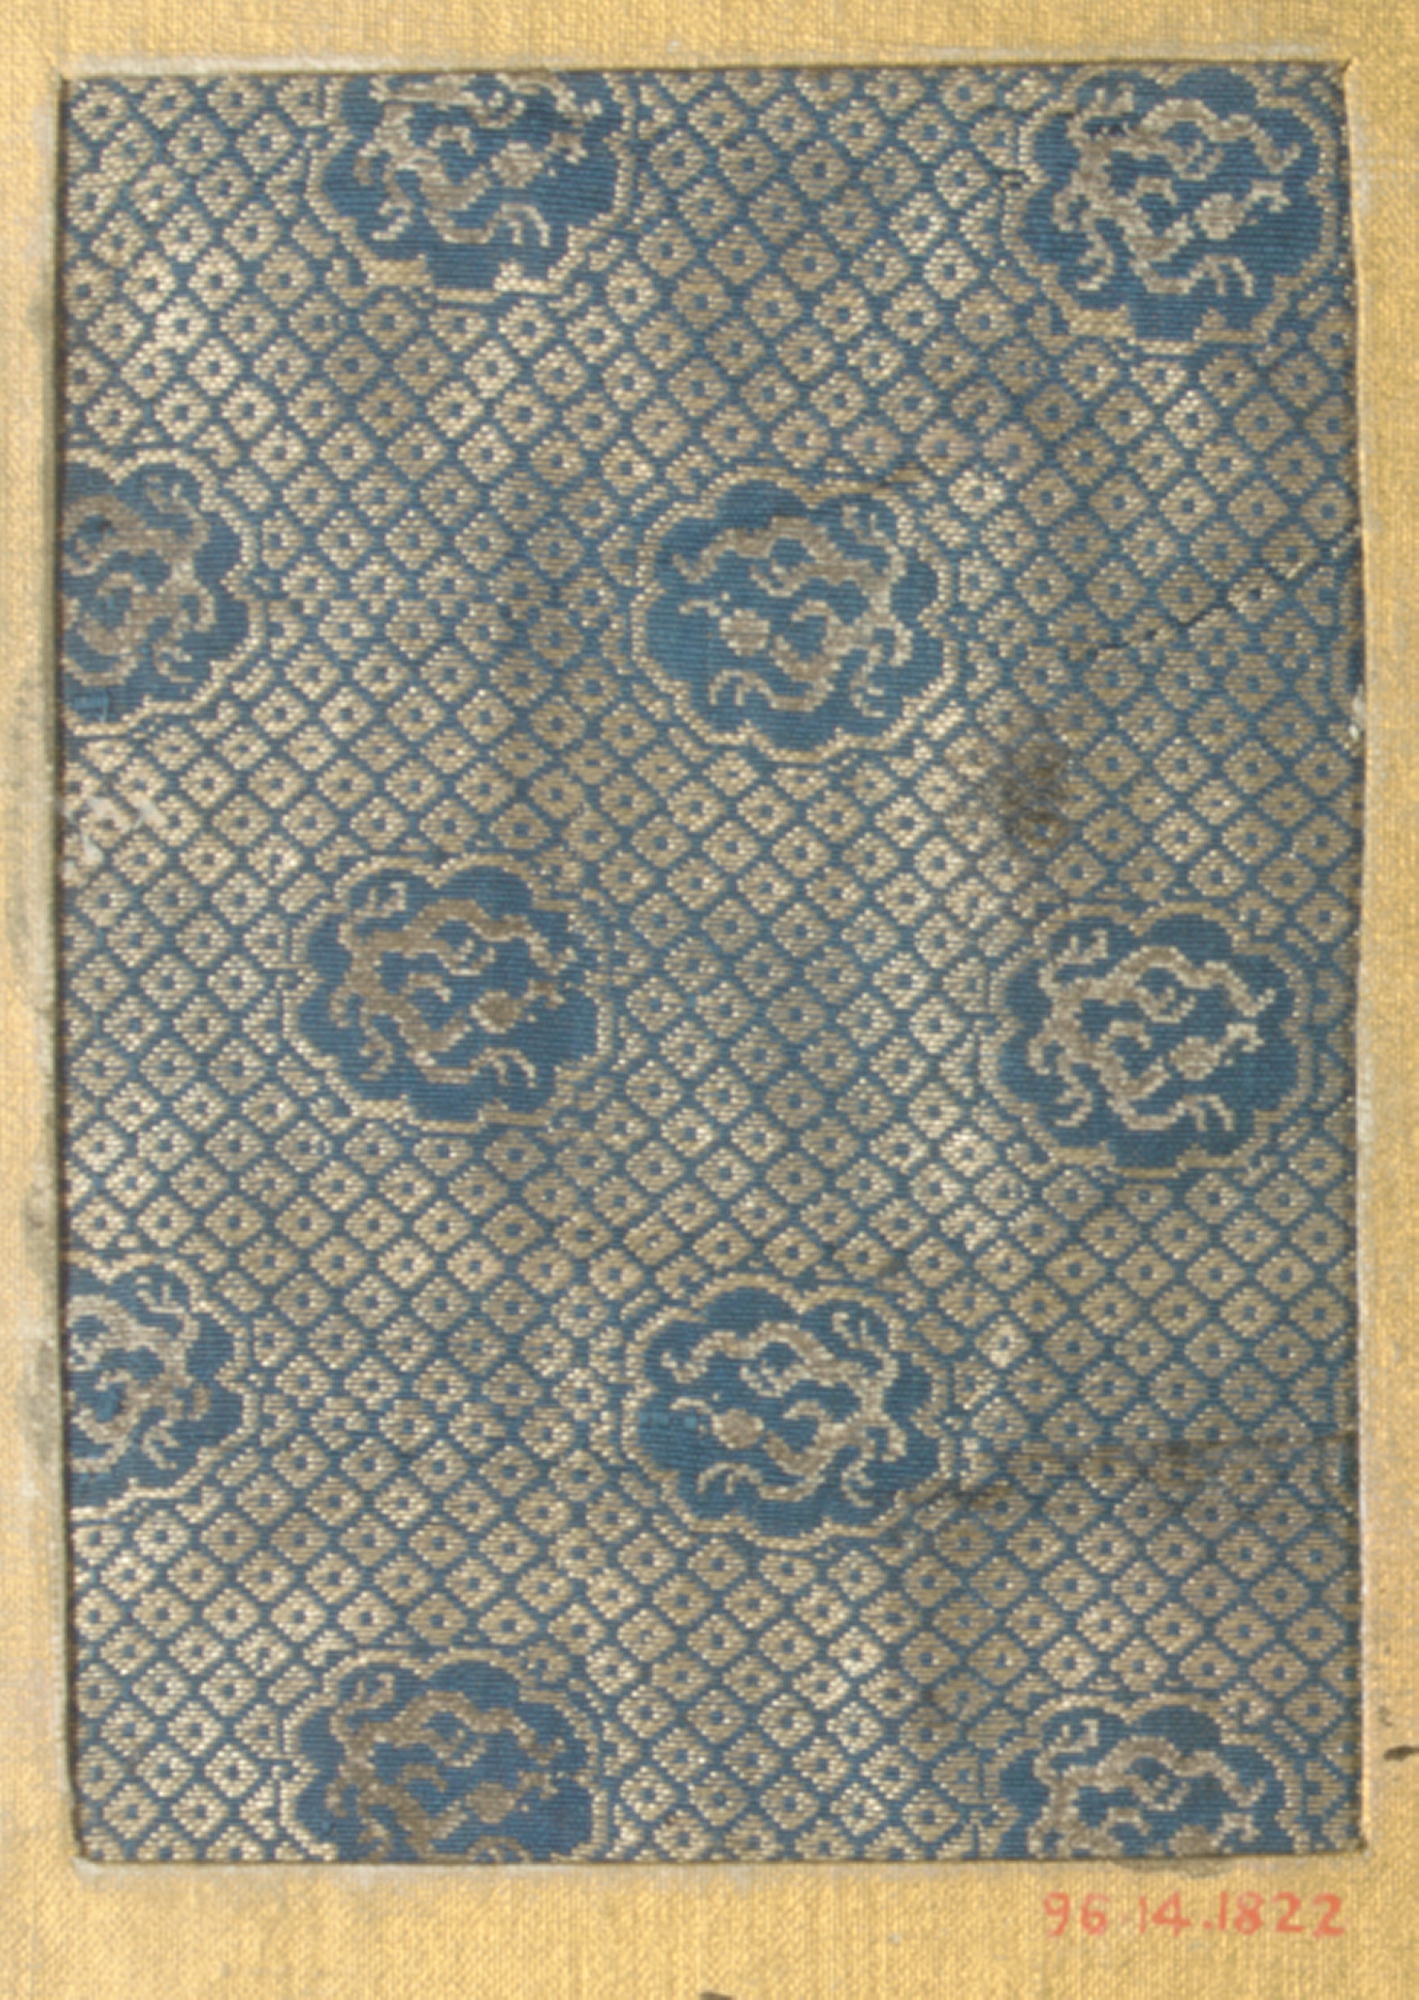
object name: piece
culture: japanese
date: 1701-1900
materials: silk